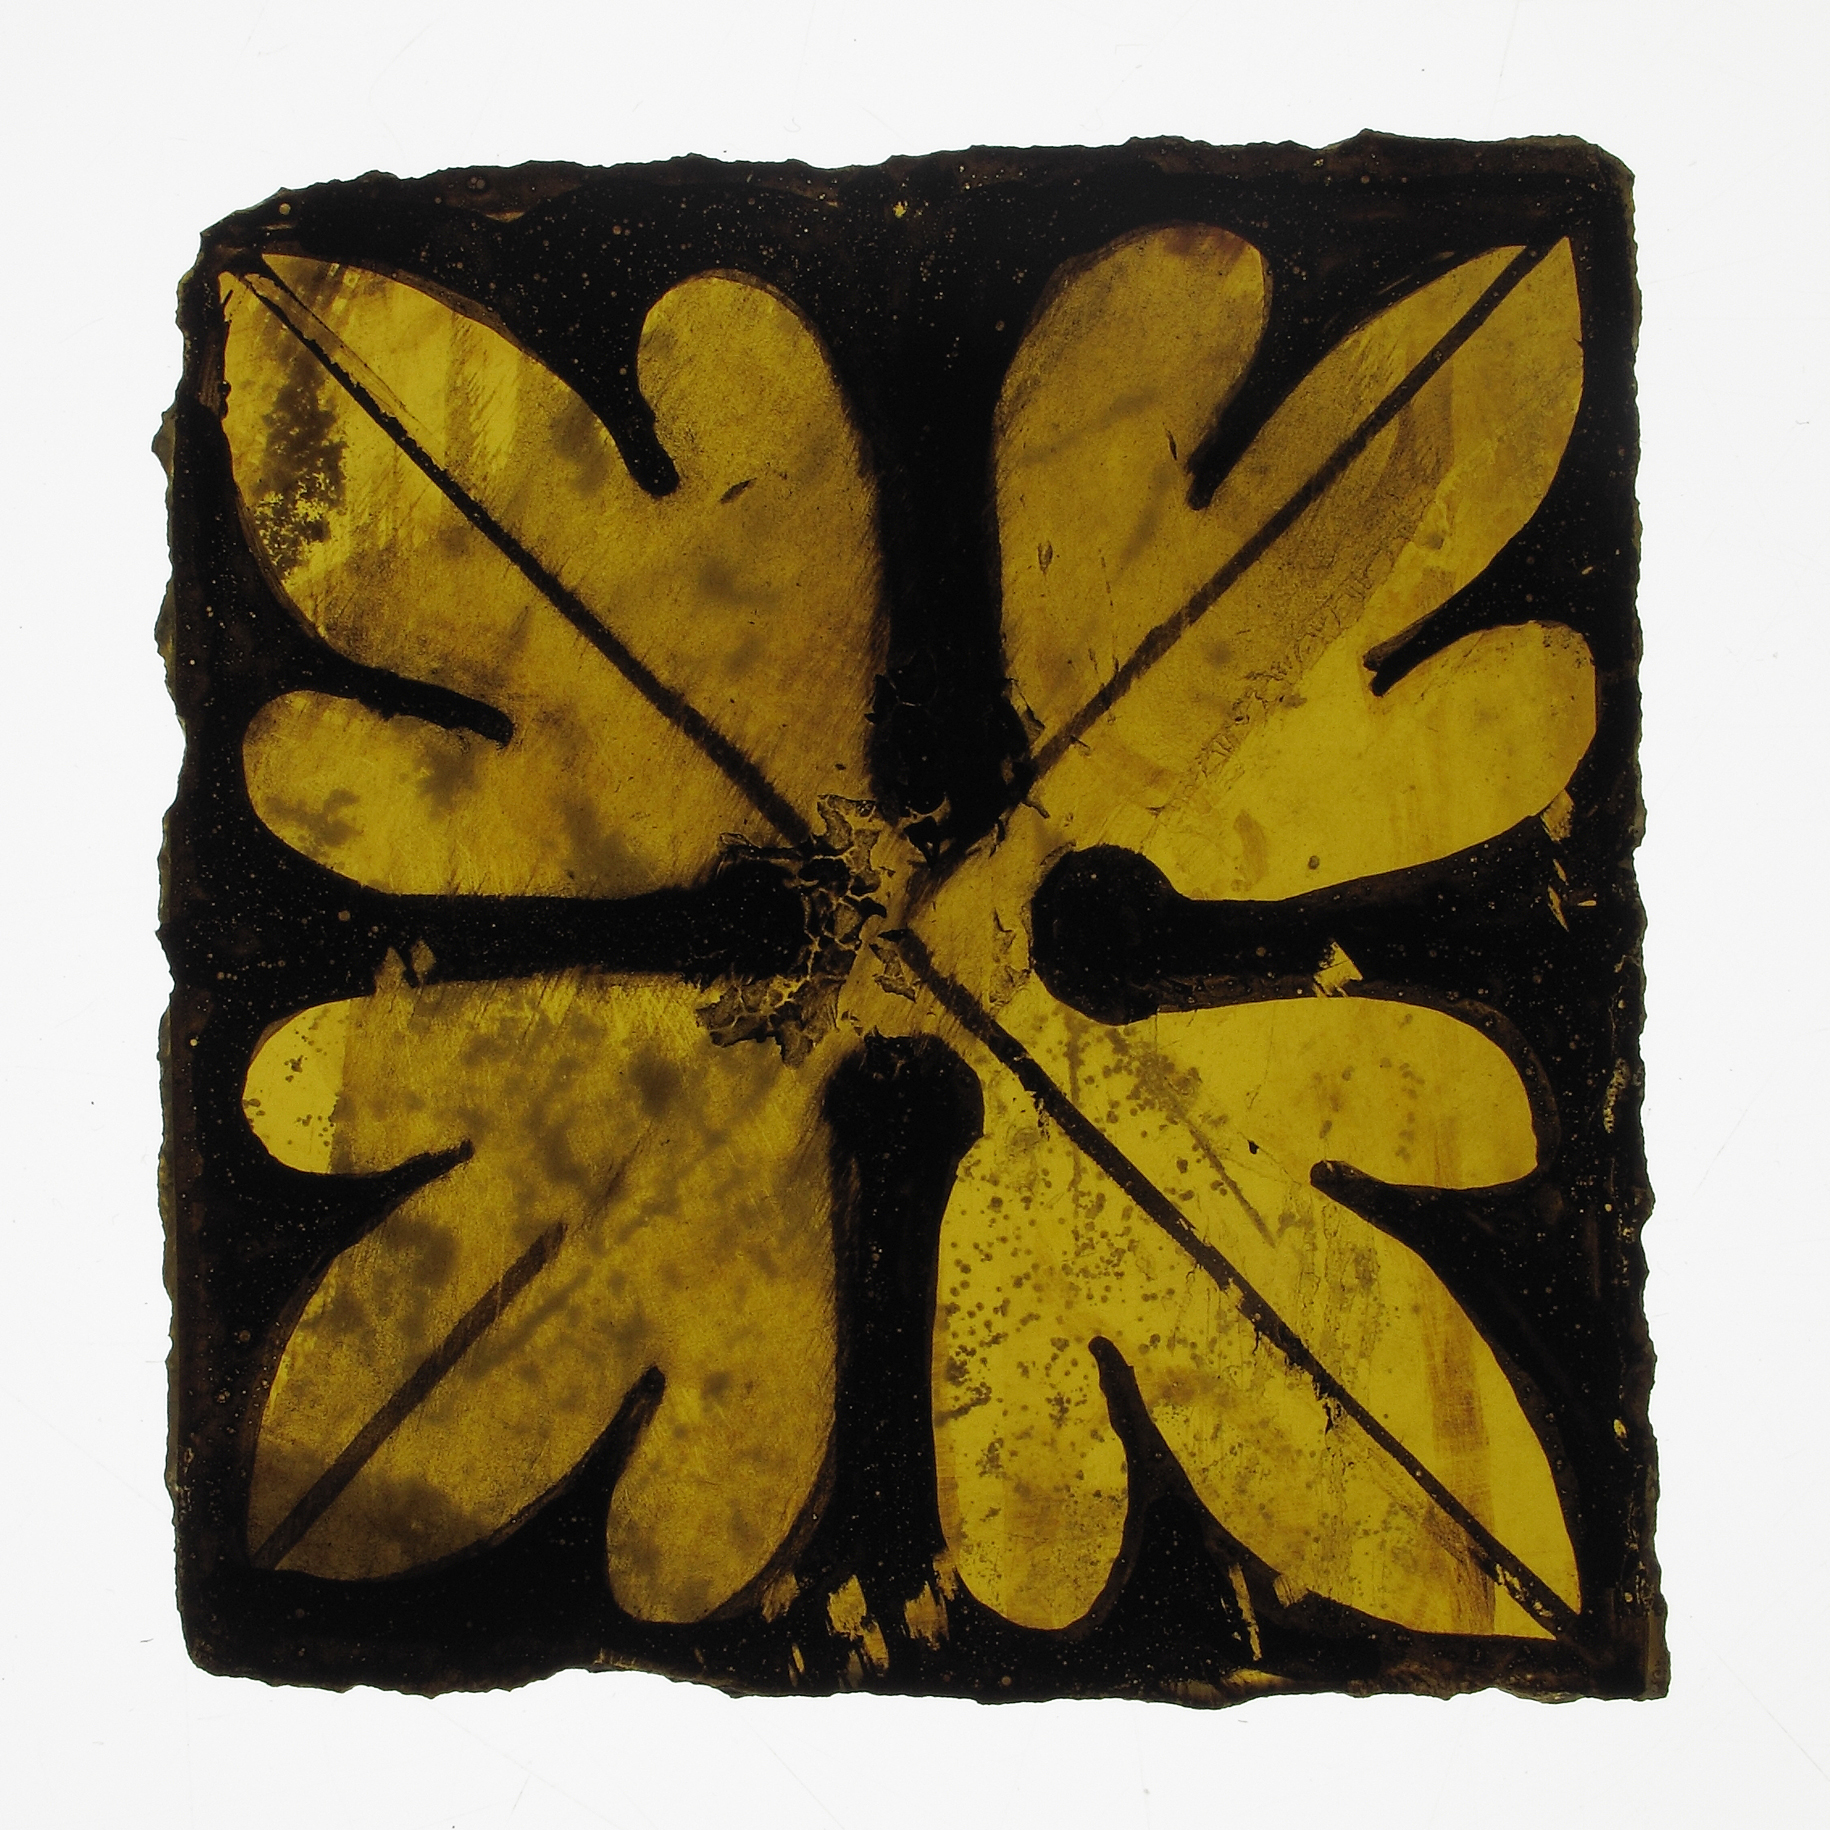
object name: fragment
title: Glass Fragment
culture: european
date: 1401-1500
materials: glass, metal